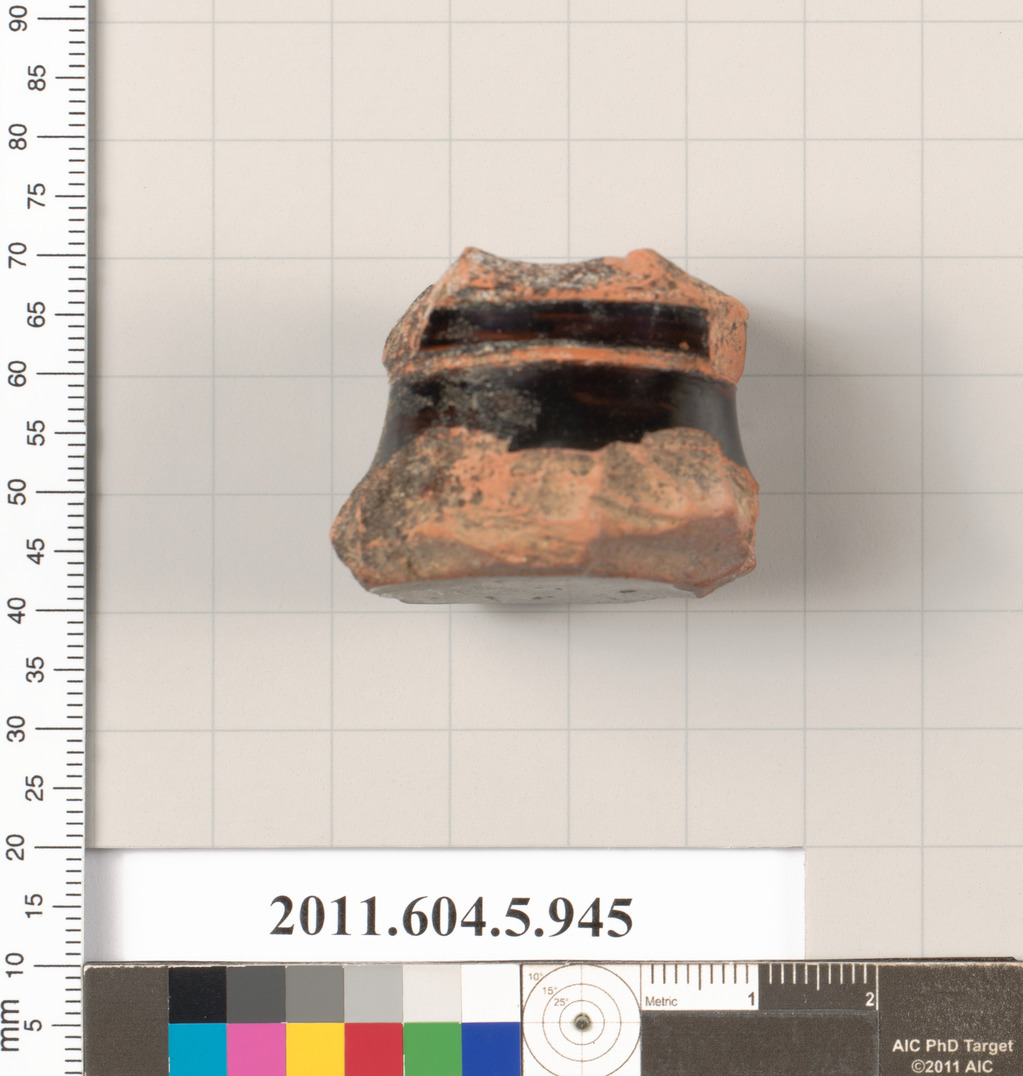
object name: kylix fragment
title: Terracotta fragment of a kylix (drinking cup)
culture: greek, attic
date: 600-401 BCE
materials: terracotta